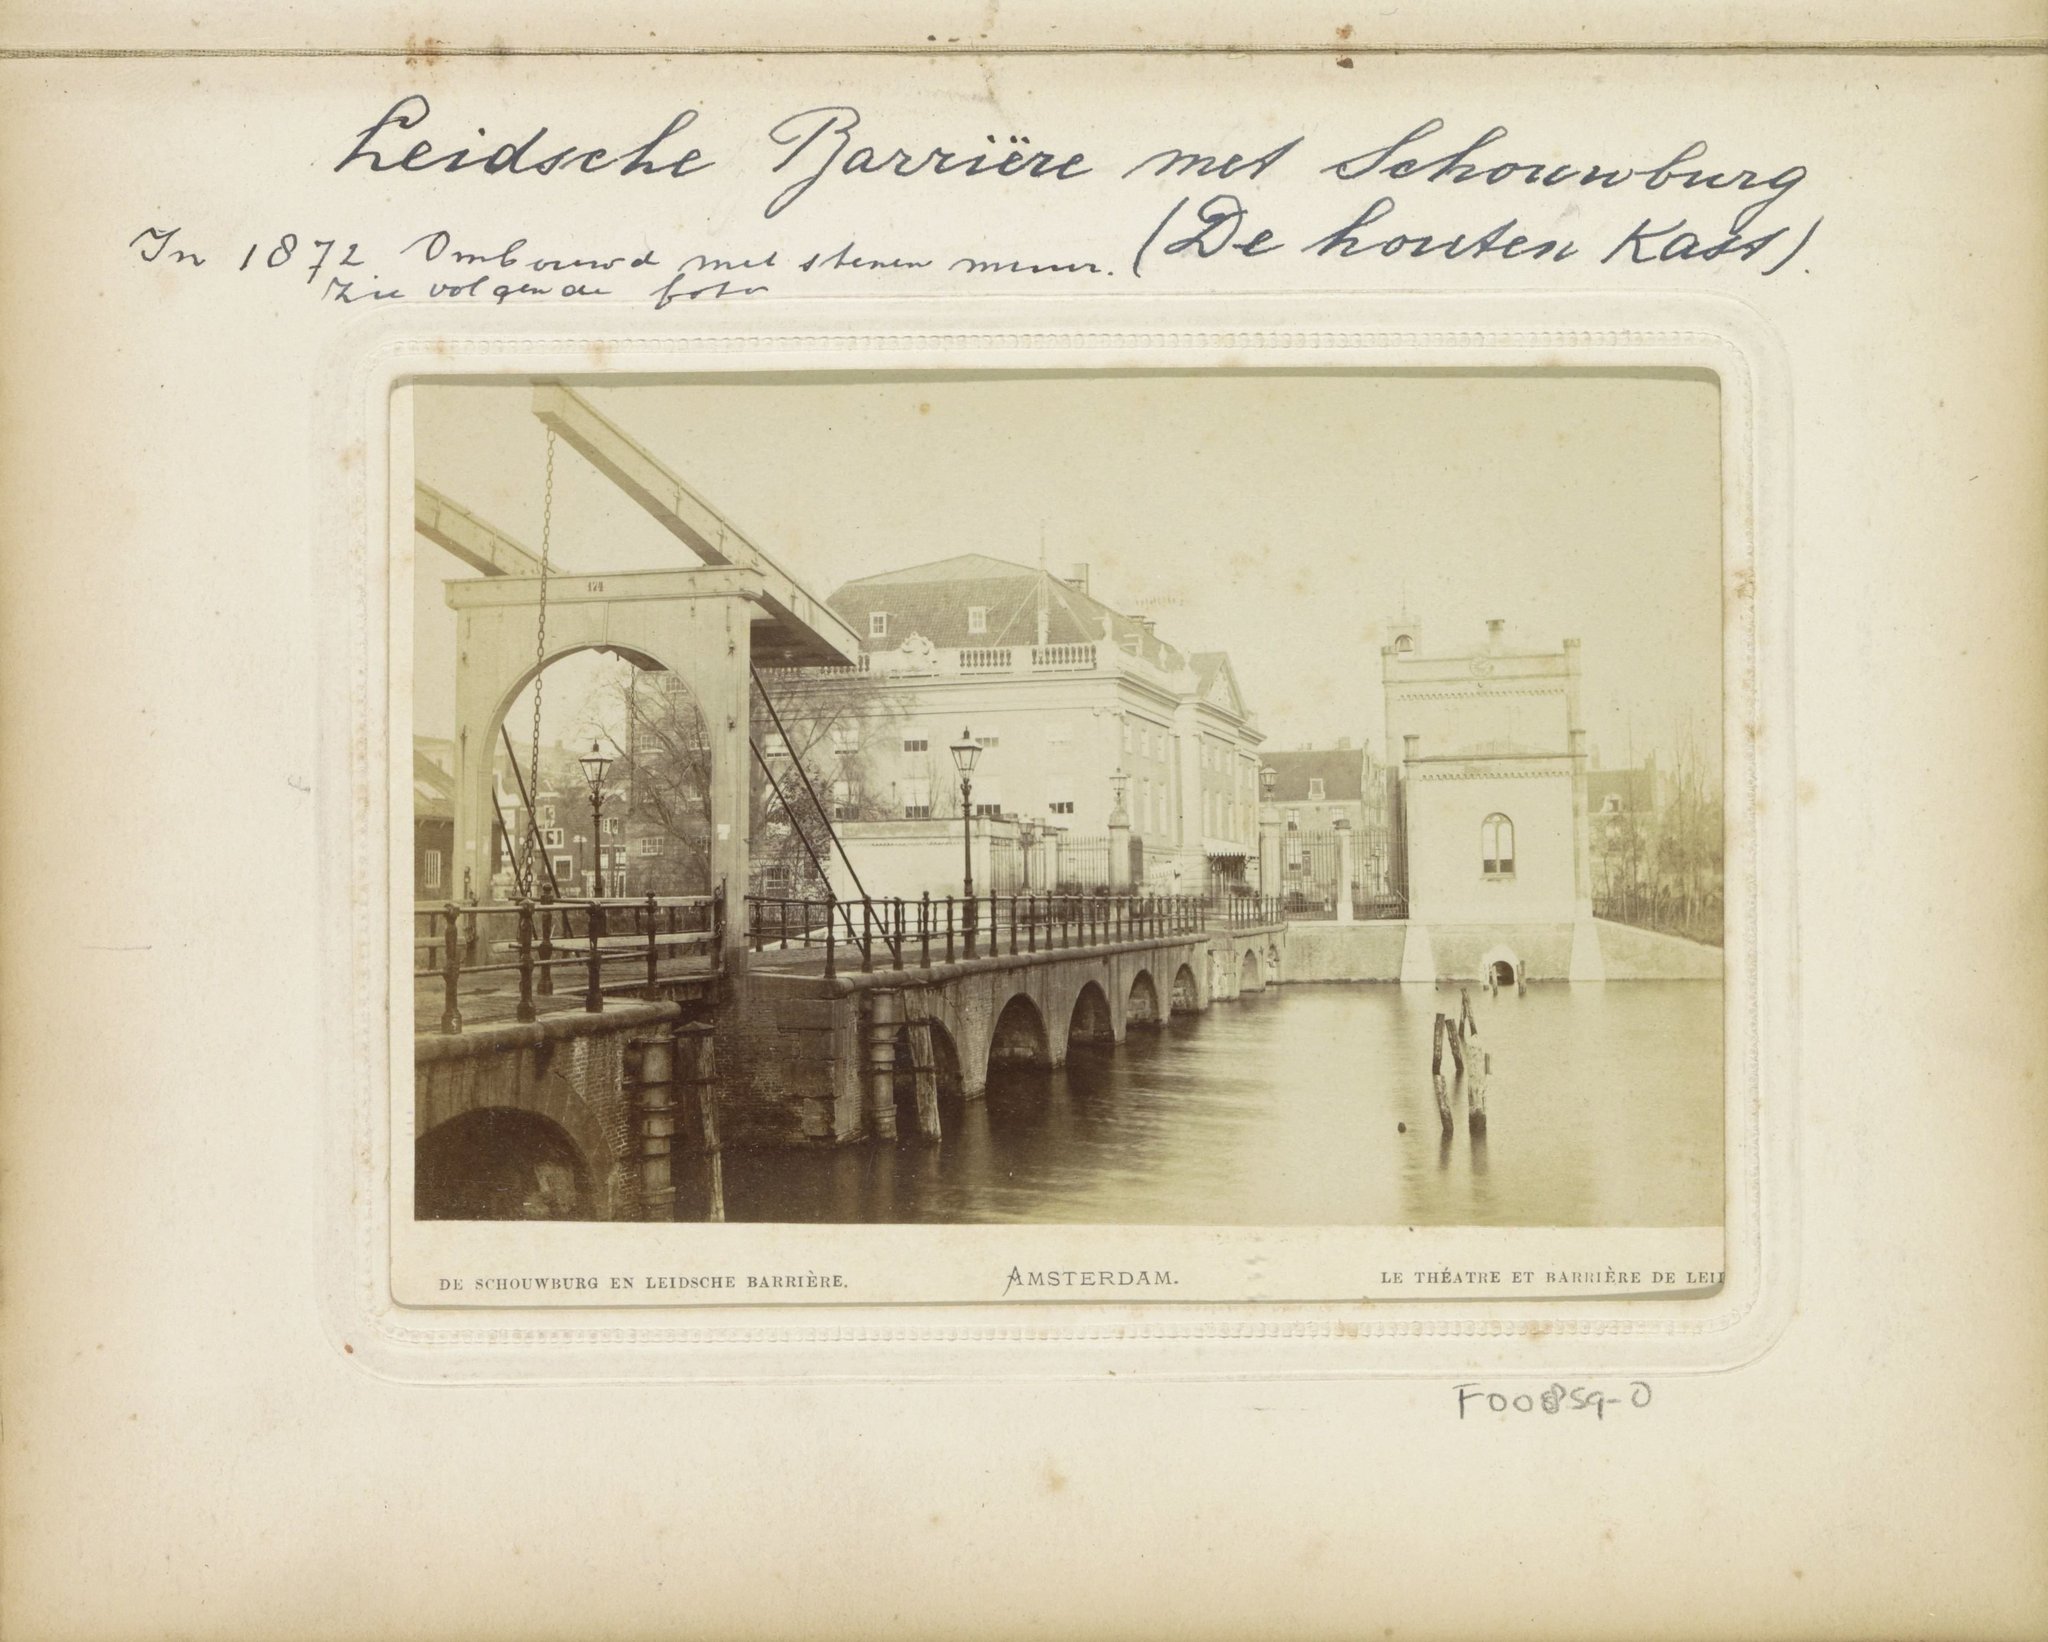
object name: cabinet photograph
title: De schouwburg en Leidsche Barrière. Amsterdam. Le théatre et Barrière de Leide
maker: andries jager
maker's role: publisher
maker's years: 1825-1905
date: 1862-1872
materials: cardboard, paper, photographic support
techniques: albumen print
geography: amsterdam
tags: theatre (building), bridge in city across river, canal, etc., prospect of city, town panorama, silhouette of city, amsterdam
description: Onderdeel van Fotoalbum met opnames van straten, pleinen en grachten in Amsterdam.